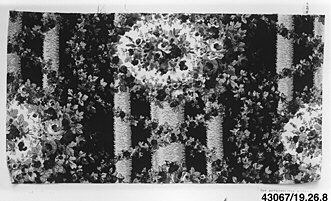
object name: sample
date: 1840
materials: cotton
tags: flowers